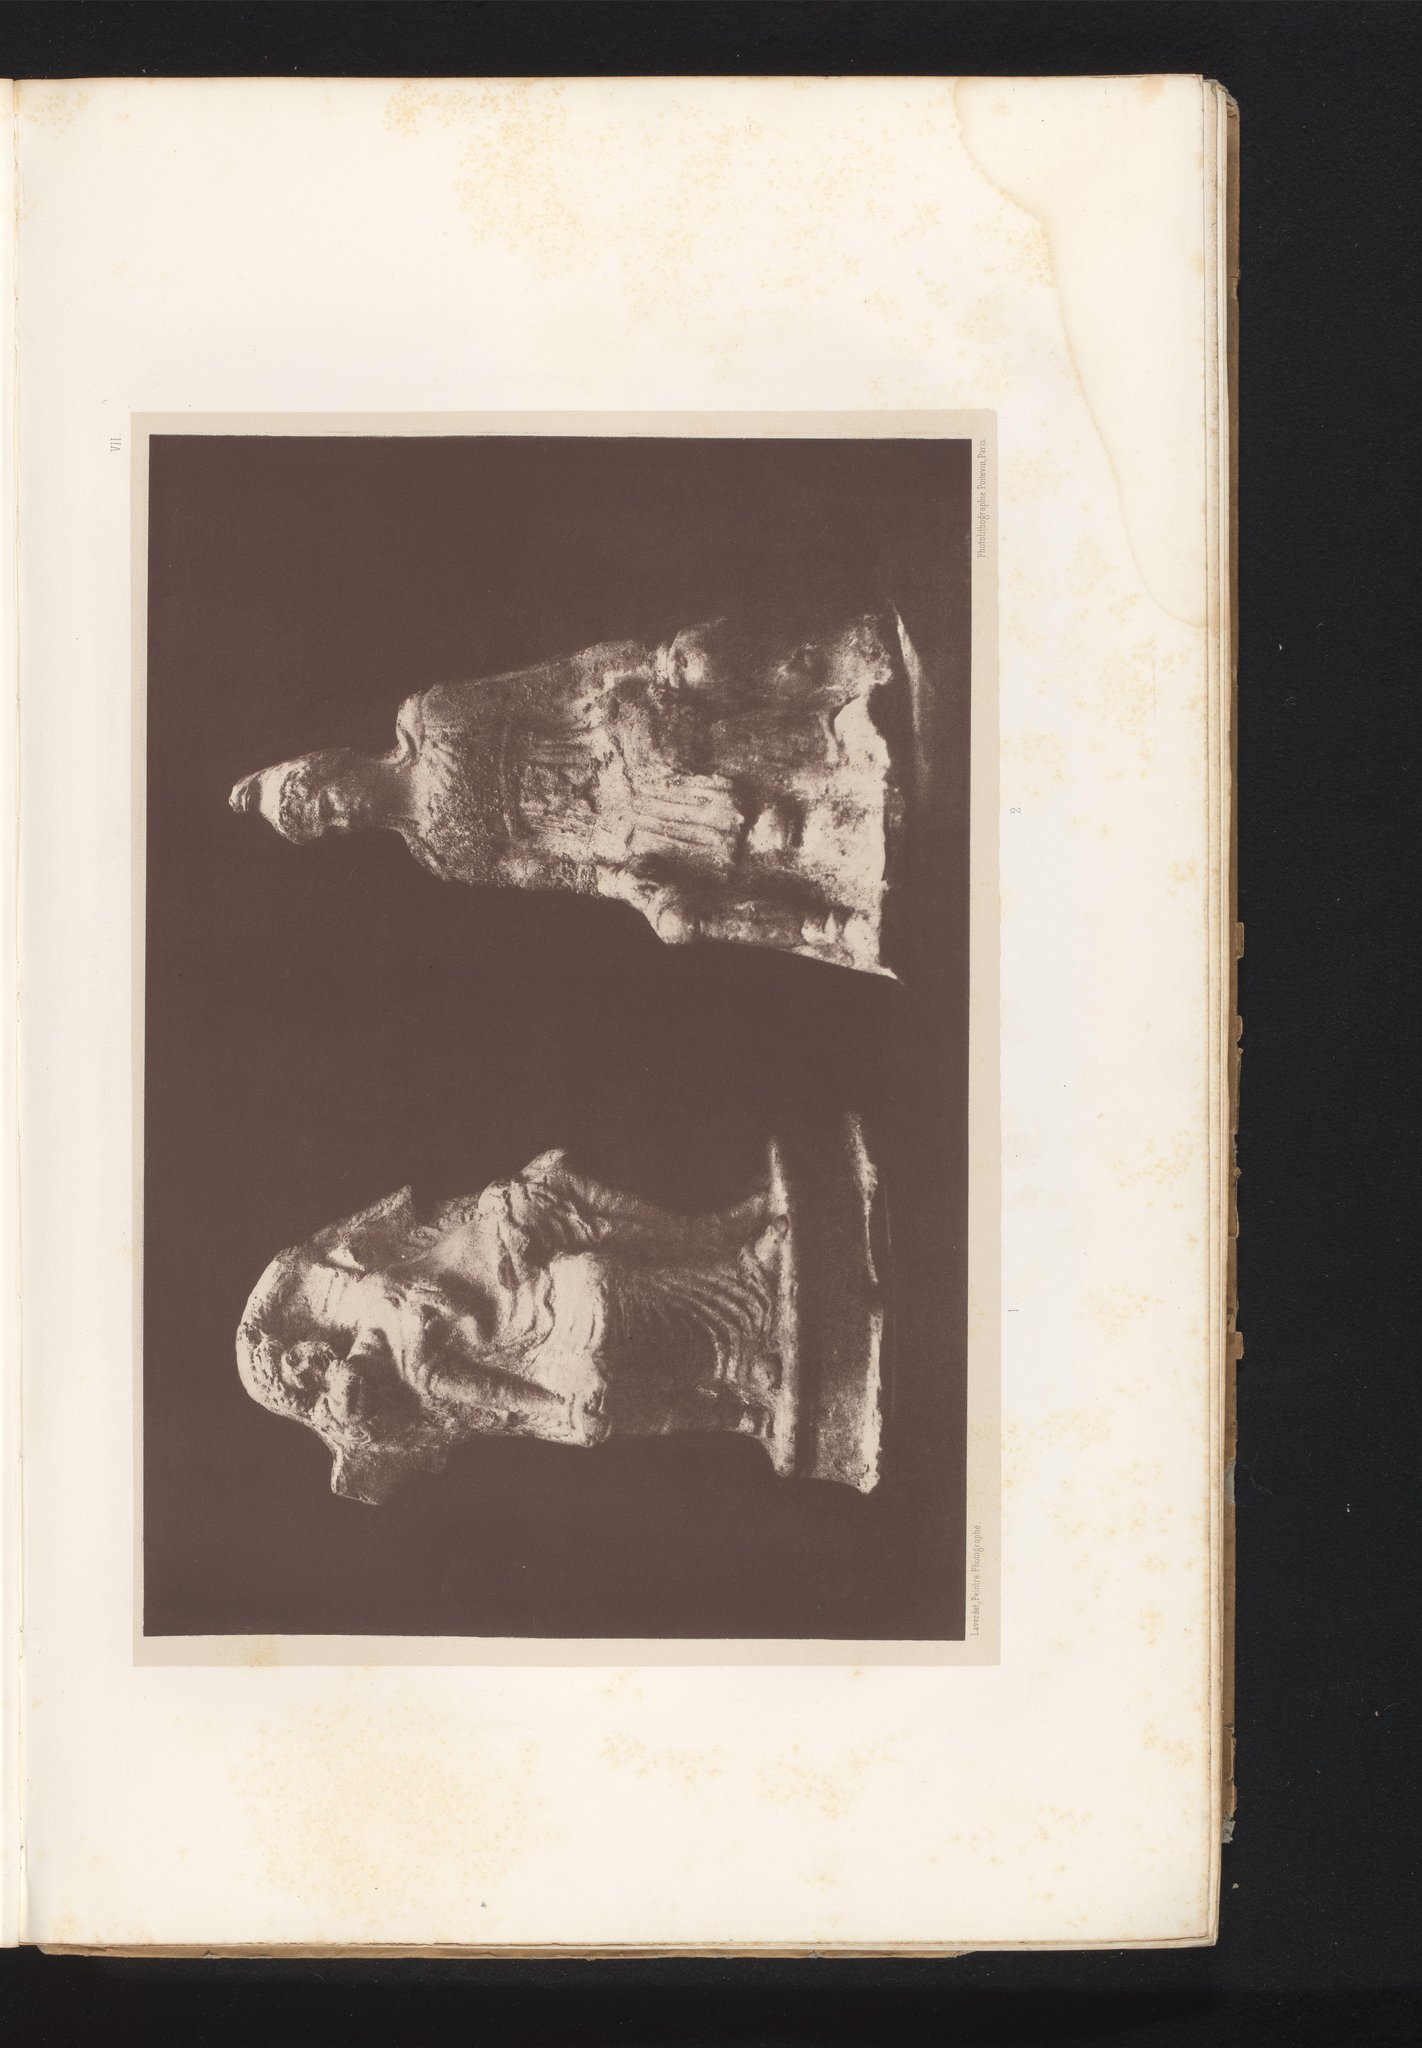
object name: photomechanical print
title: Twee terracotta sculpturen van twee vrouwen in gewaad en een zittende Paris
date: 1852-1857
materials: paper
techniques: photolithography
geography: paris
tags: piece of sculpture, reproduction of a piece of sculpture (+ clay, sand, etc. ~ arts), adult woman (+ two persons), (story of) paris (alexander)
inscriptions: number: ‘VII.’, number: ‘1. 2.’